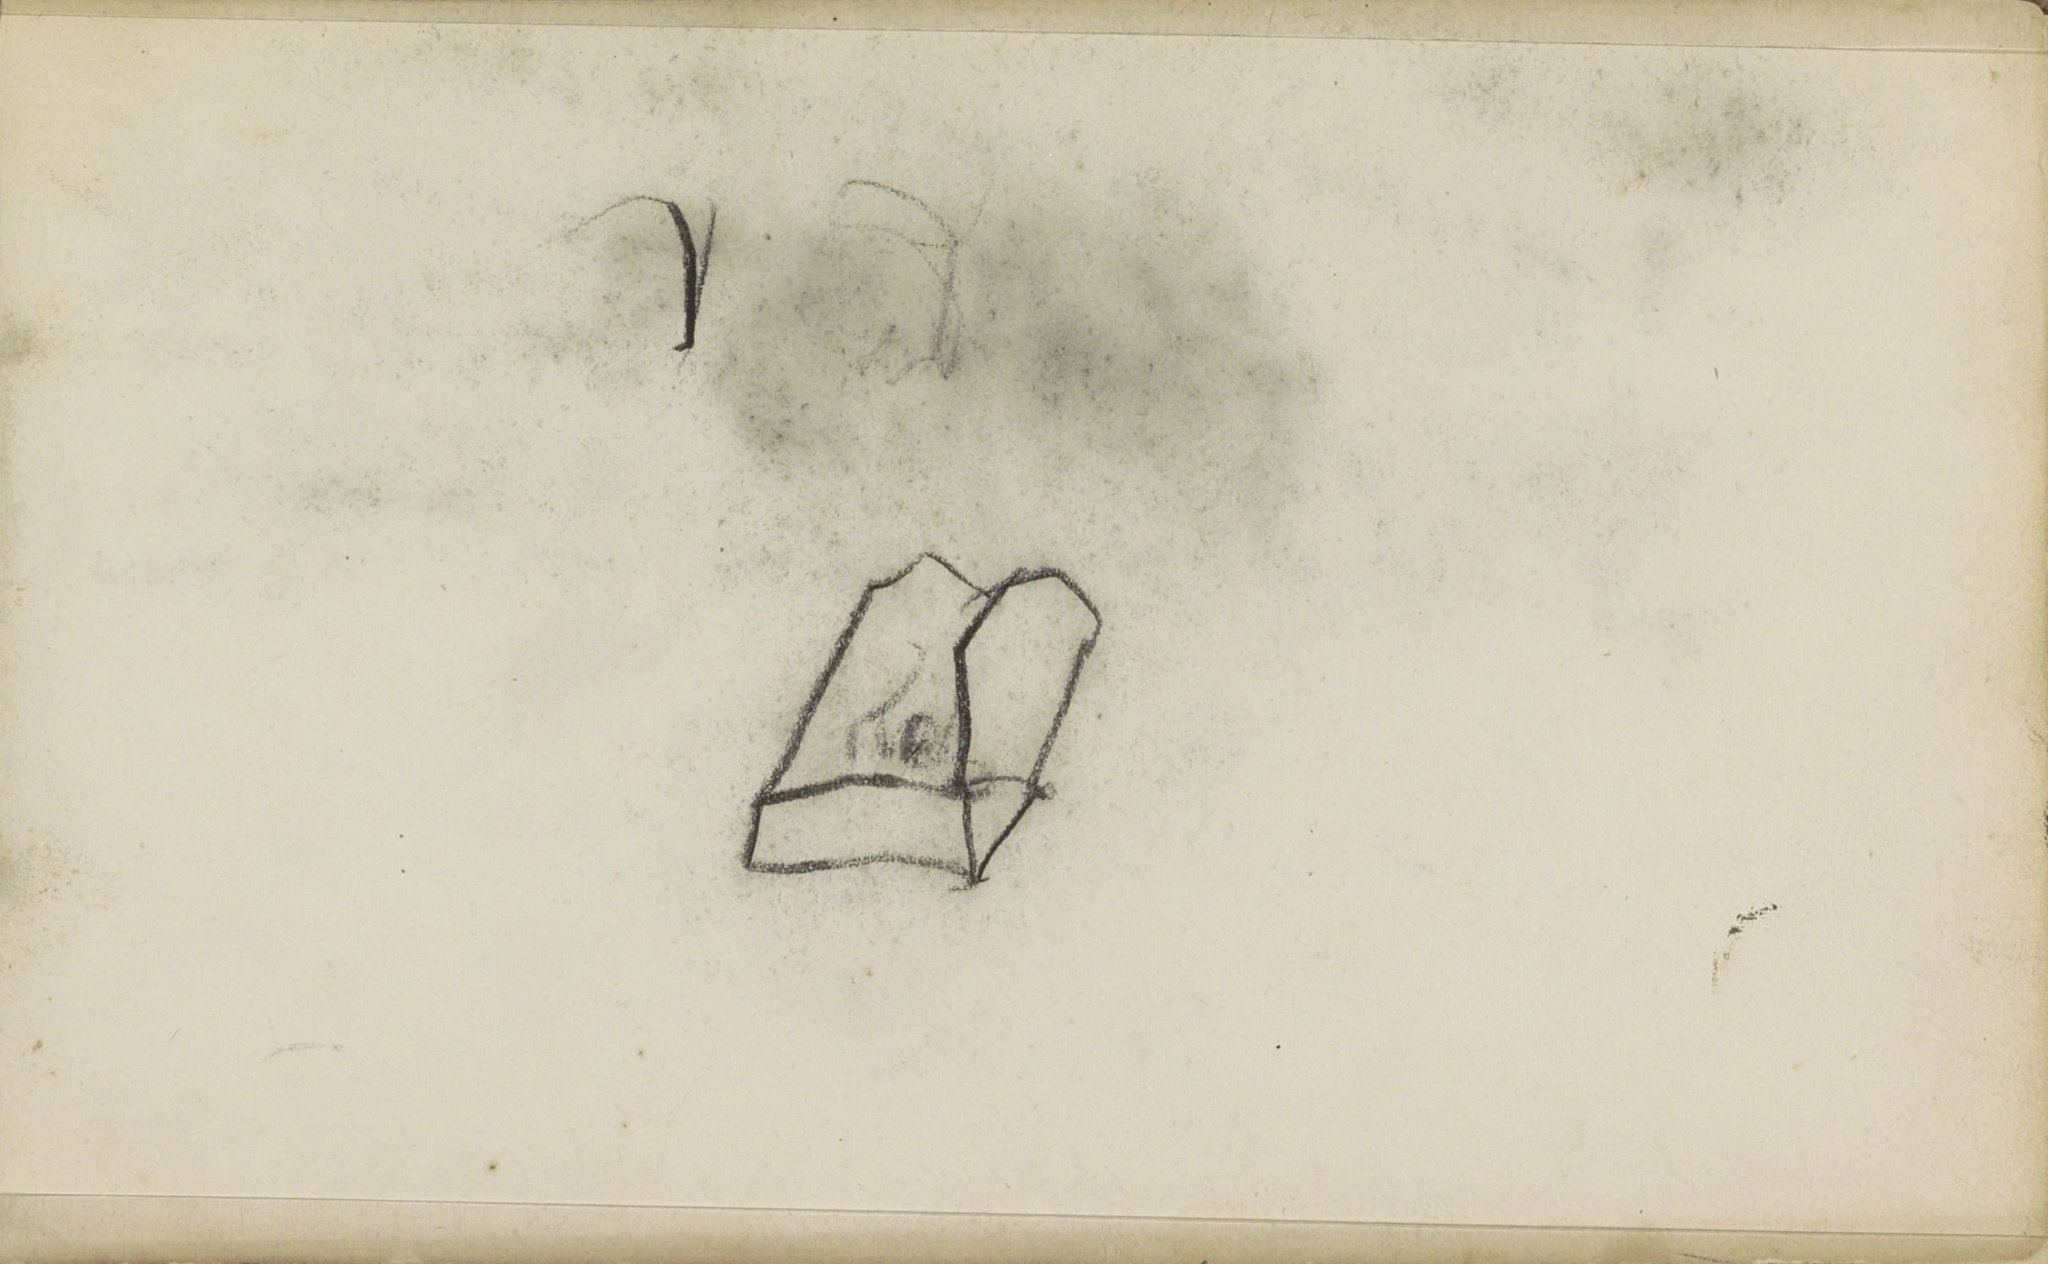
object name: sketchbook leaf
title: Studie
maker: jozef israëls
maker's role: draughtsman, painter, print maker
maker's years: 1824-1911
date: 1834-1911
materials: chalk, paper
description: Blad 33 recto uit een schetsboek met 42 bladen.